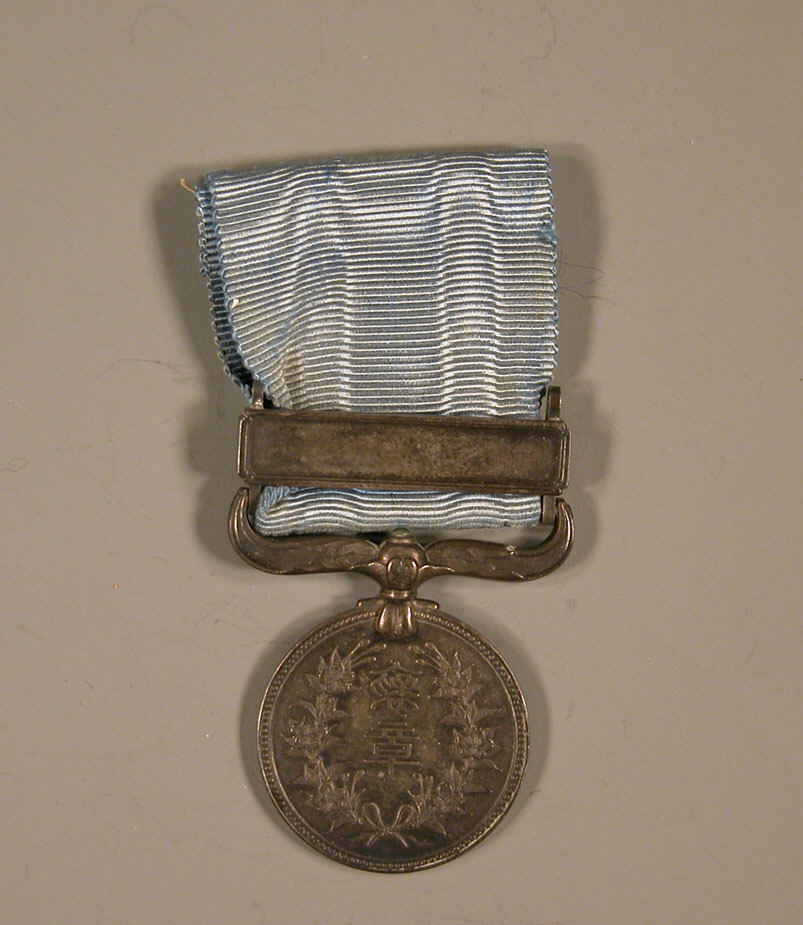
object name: medal of honor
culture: japanese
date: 1867-1900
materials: ribbon